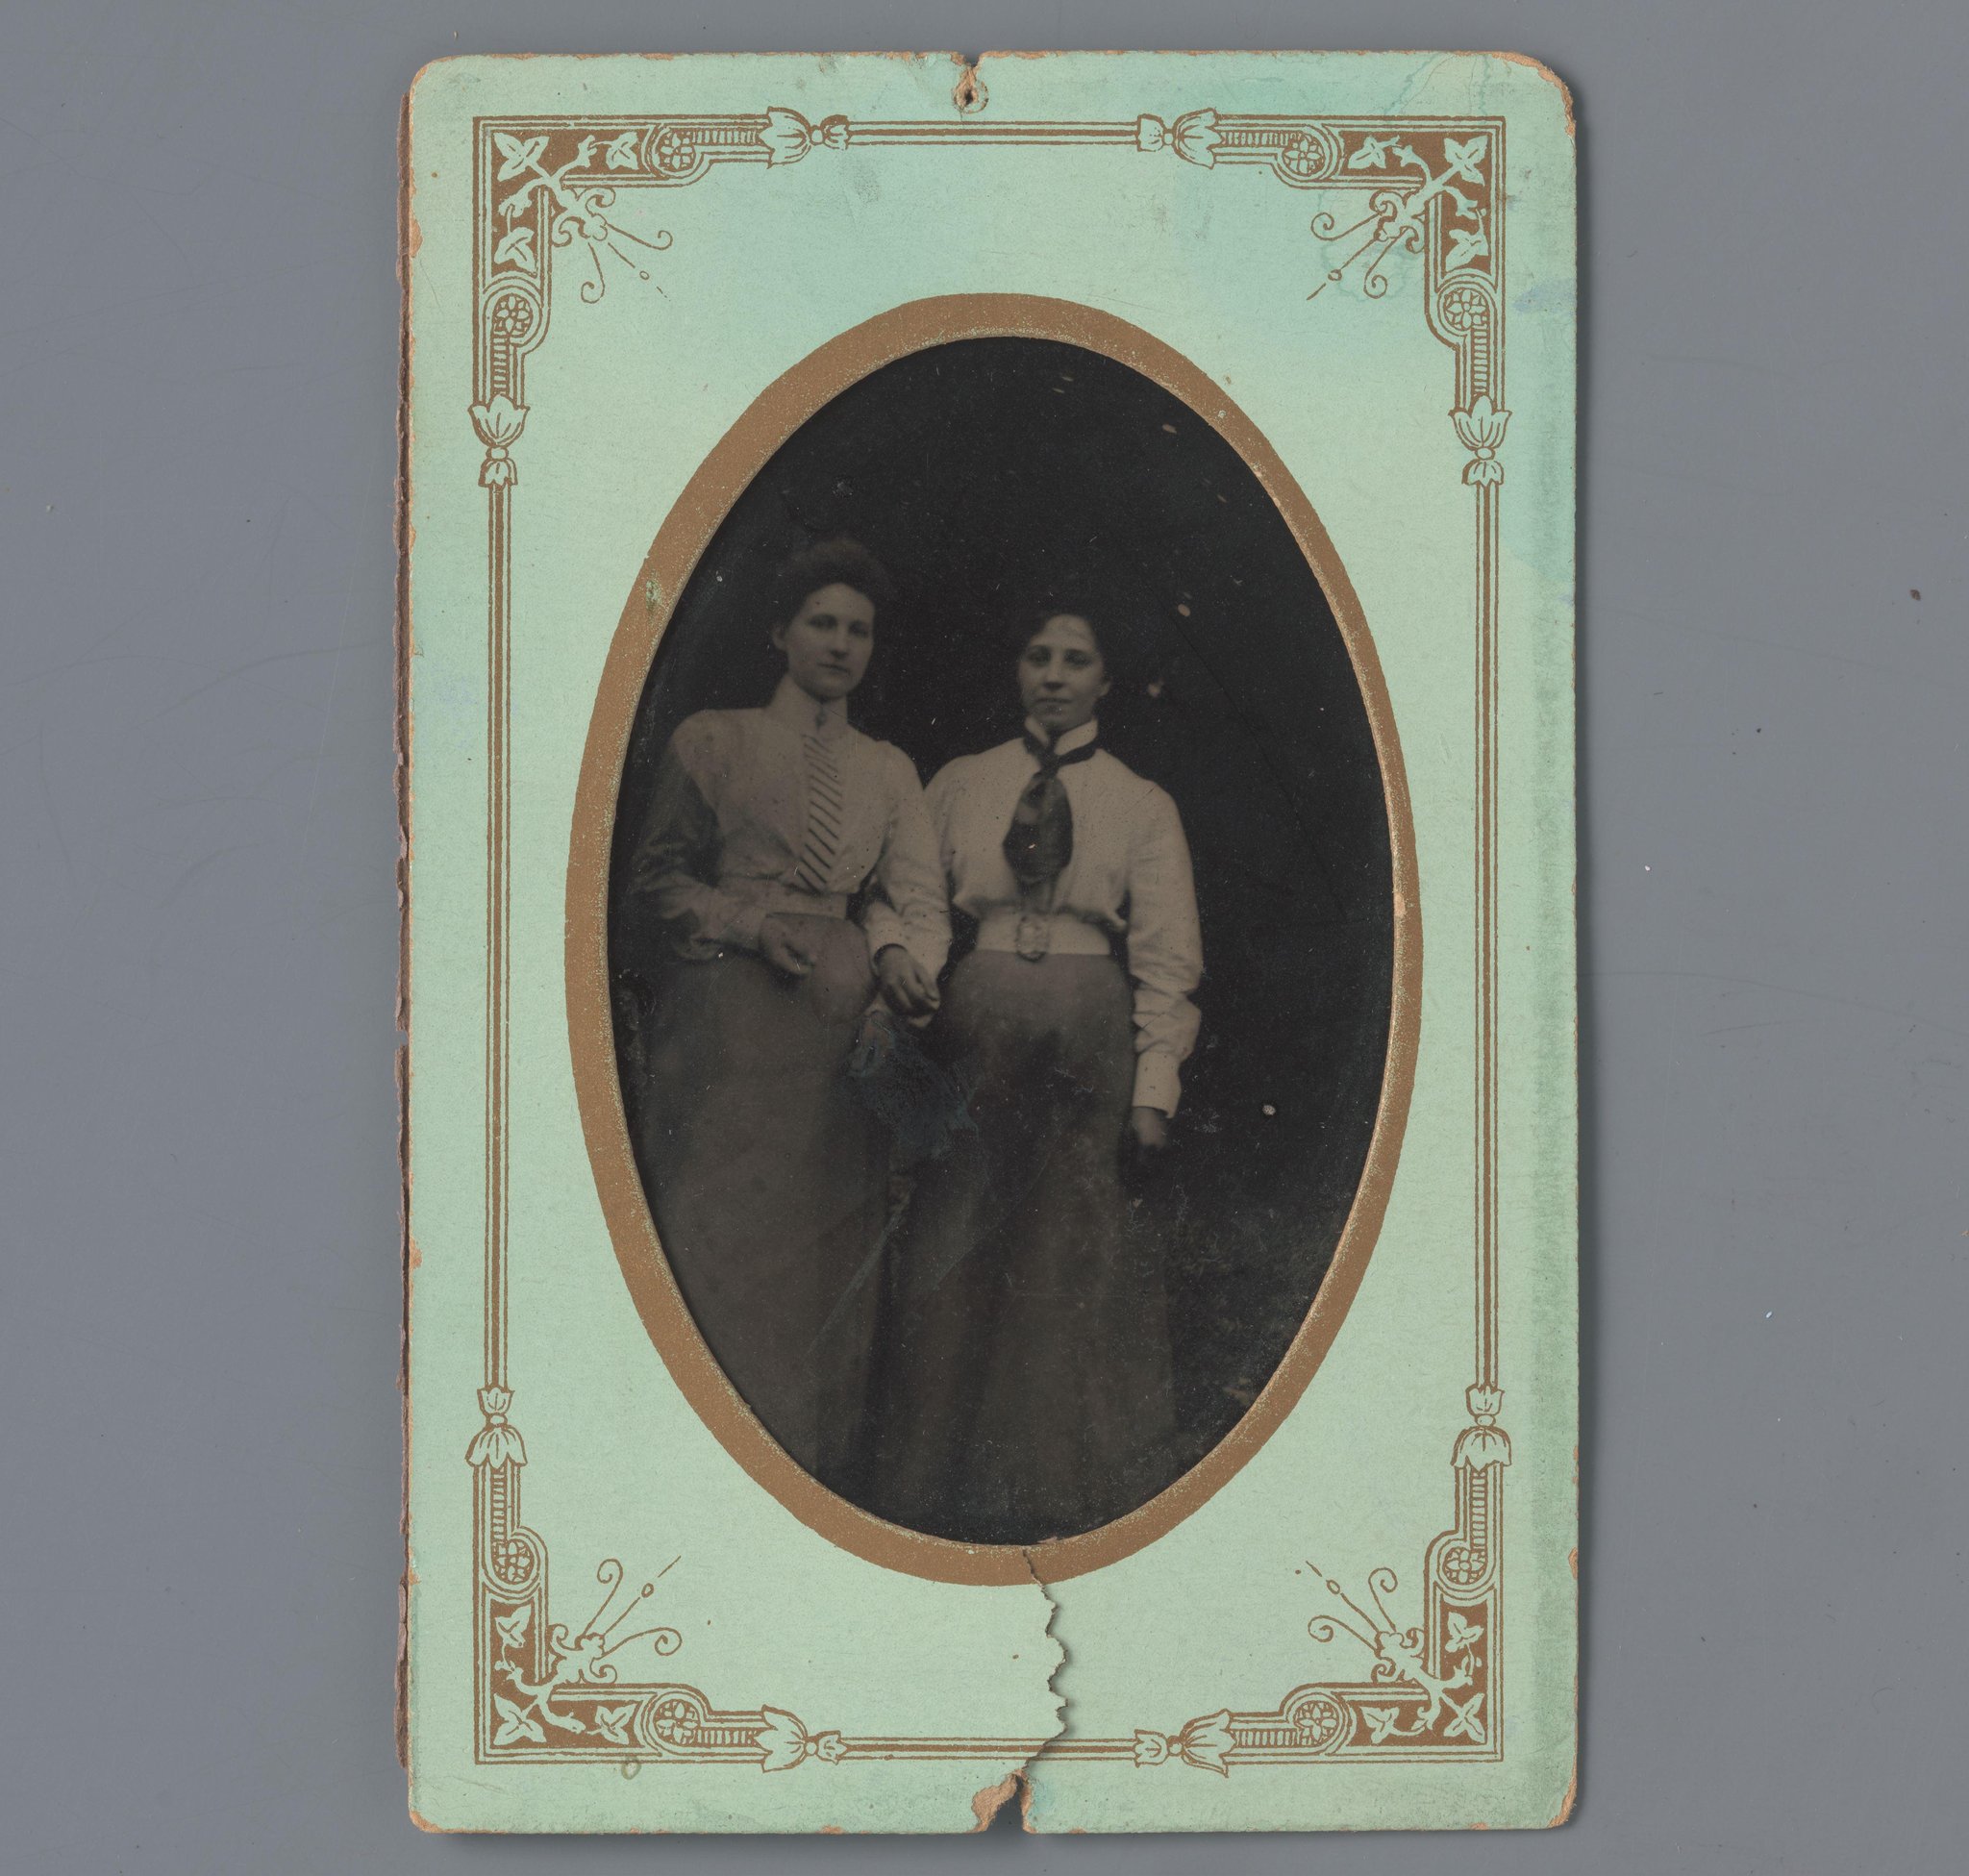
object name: photograph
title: Portrait of two unknown women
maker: Anonymous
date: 1855-1940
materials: cardboard, iron, paper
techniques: ferrotyping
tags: historical persons - bb - woman